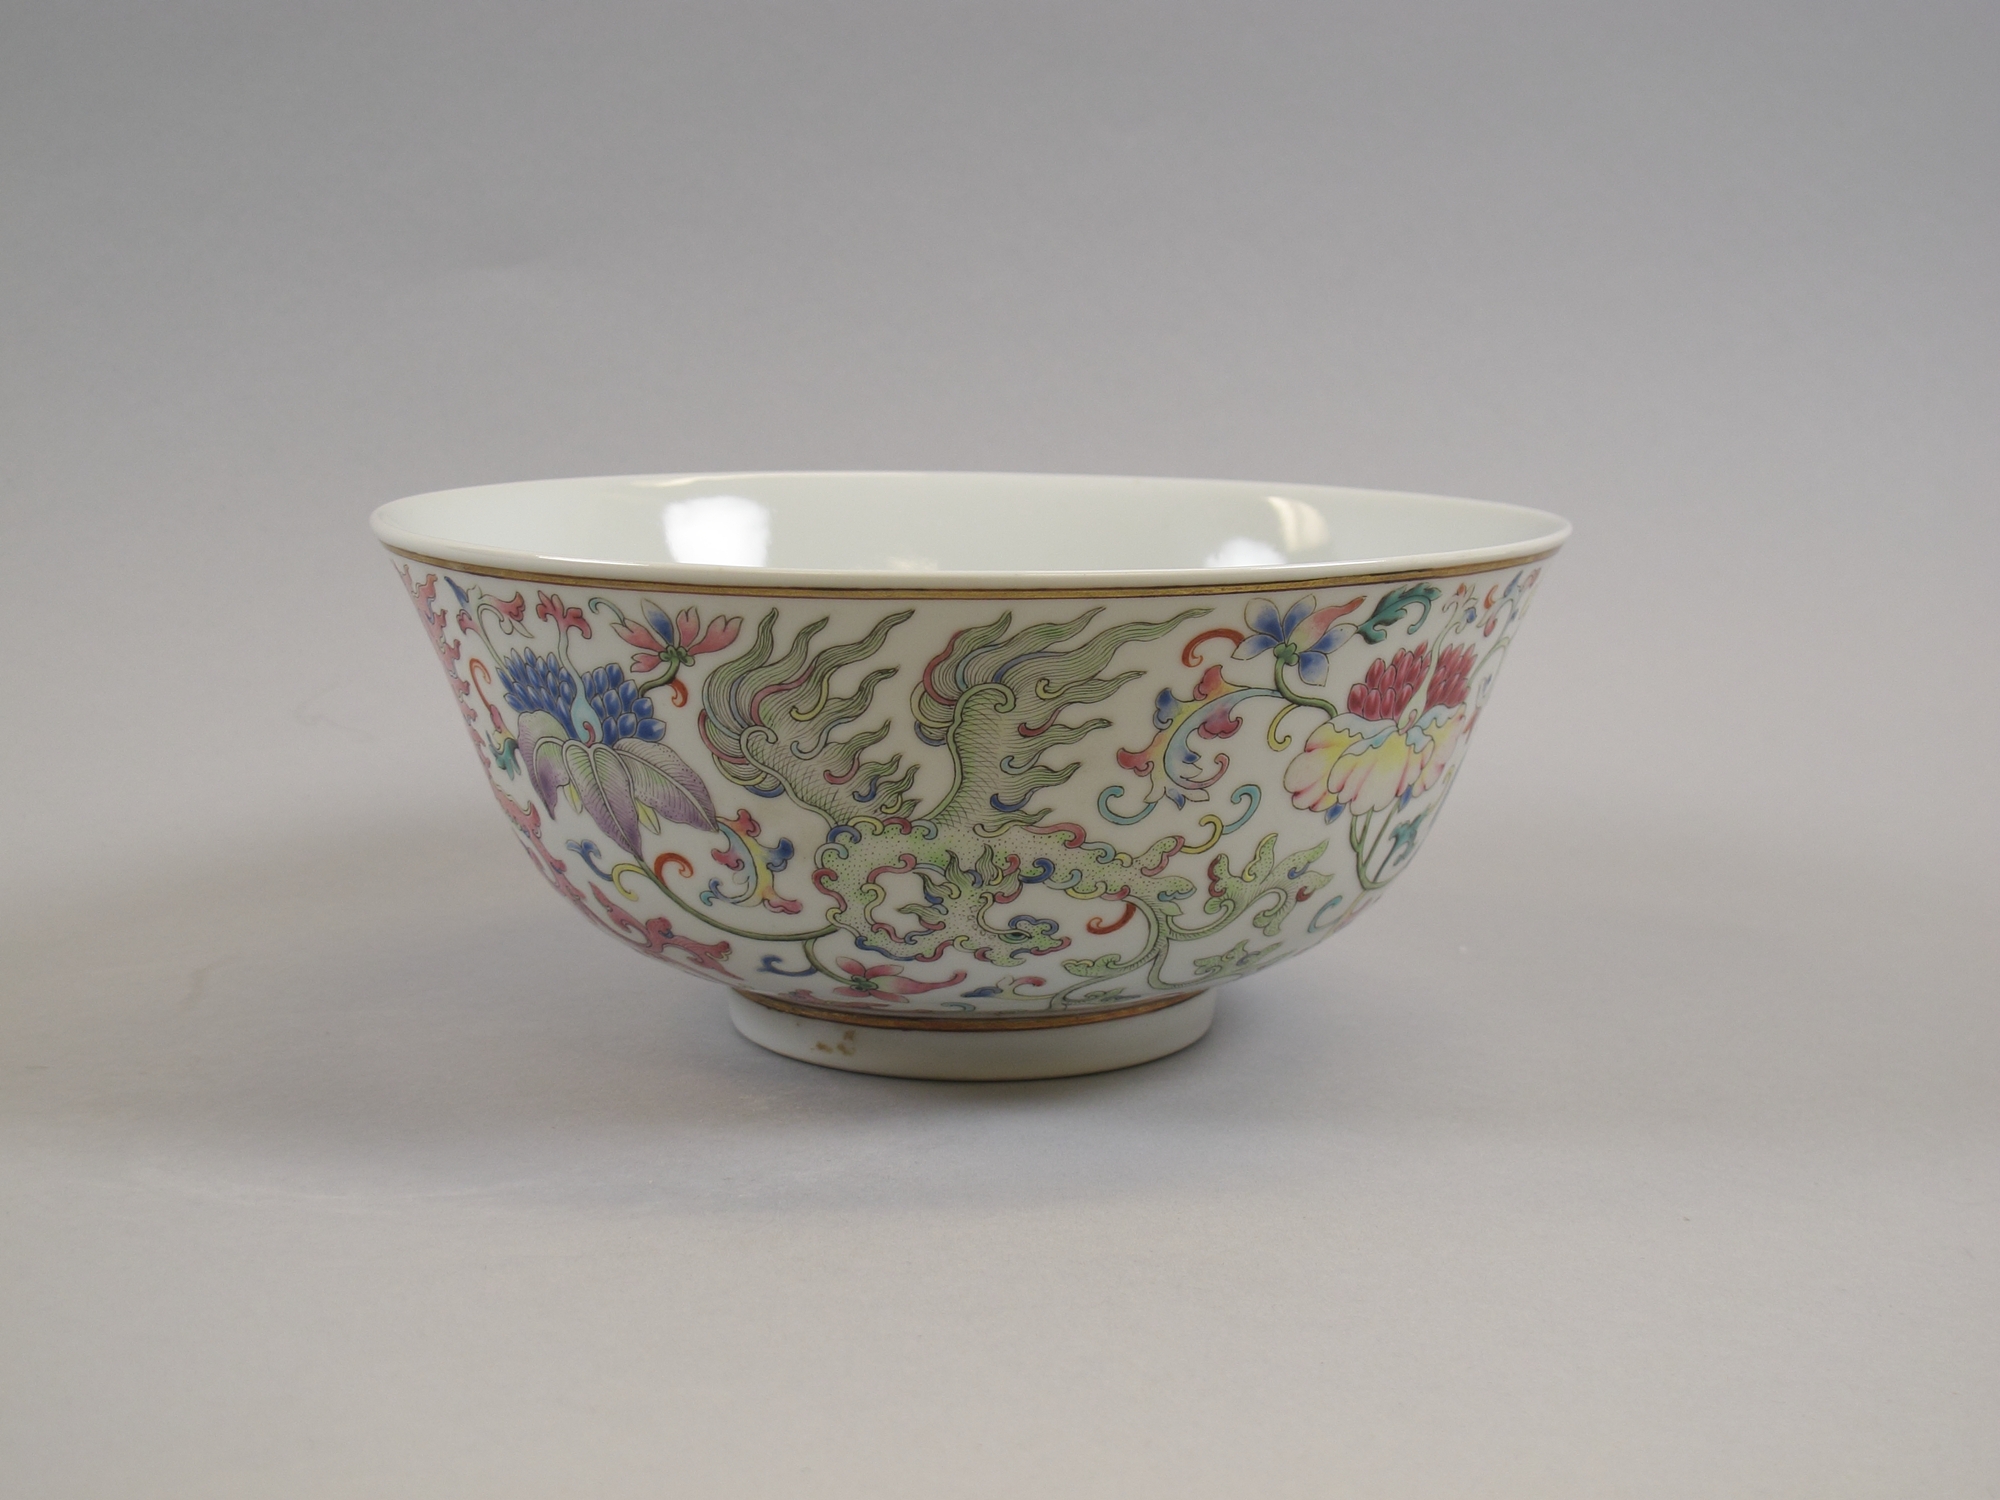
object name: bowl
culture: chinese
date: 1821-1850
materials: enamel, porcelain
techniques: overglaze, painting, polychrome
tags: dragons,flowers